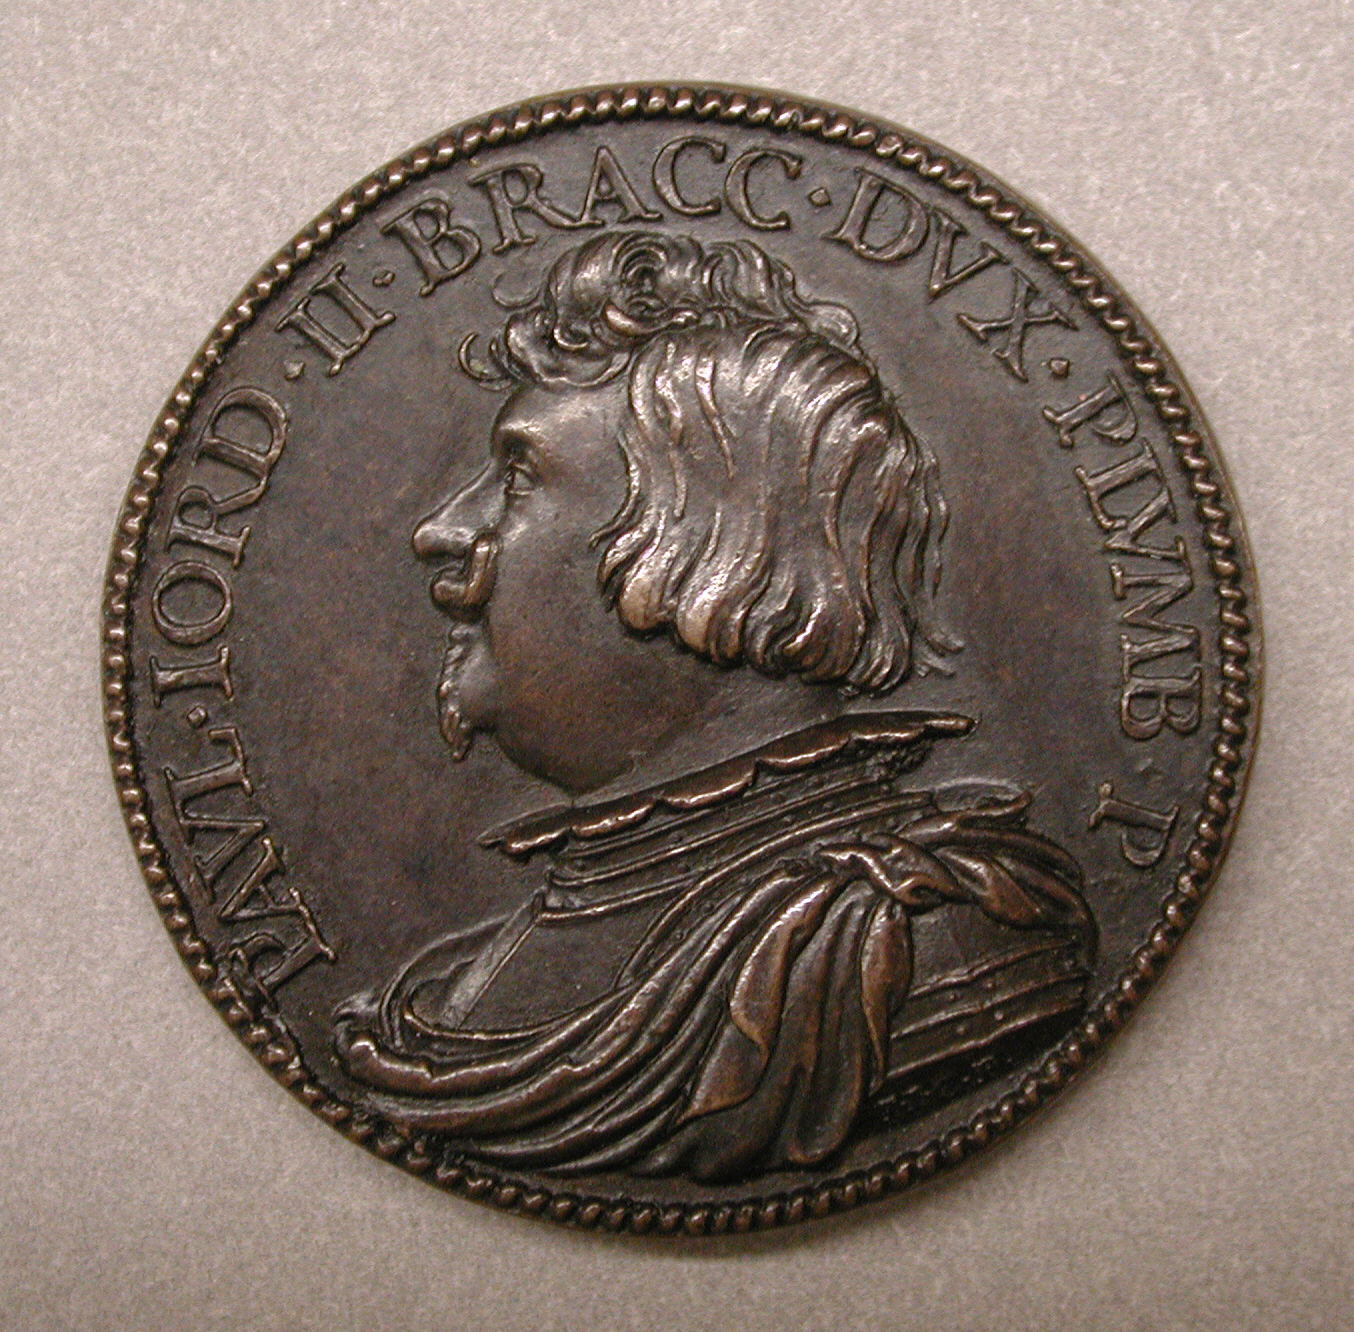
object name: medal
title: Paolo Giordano II Orsini (1591–1656)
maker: johann jakob kornmann (called cormano)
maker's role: artist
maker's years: 1620-1700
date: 1636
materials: bronze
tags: men,profiles,female nudes